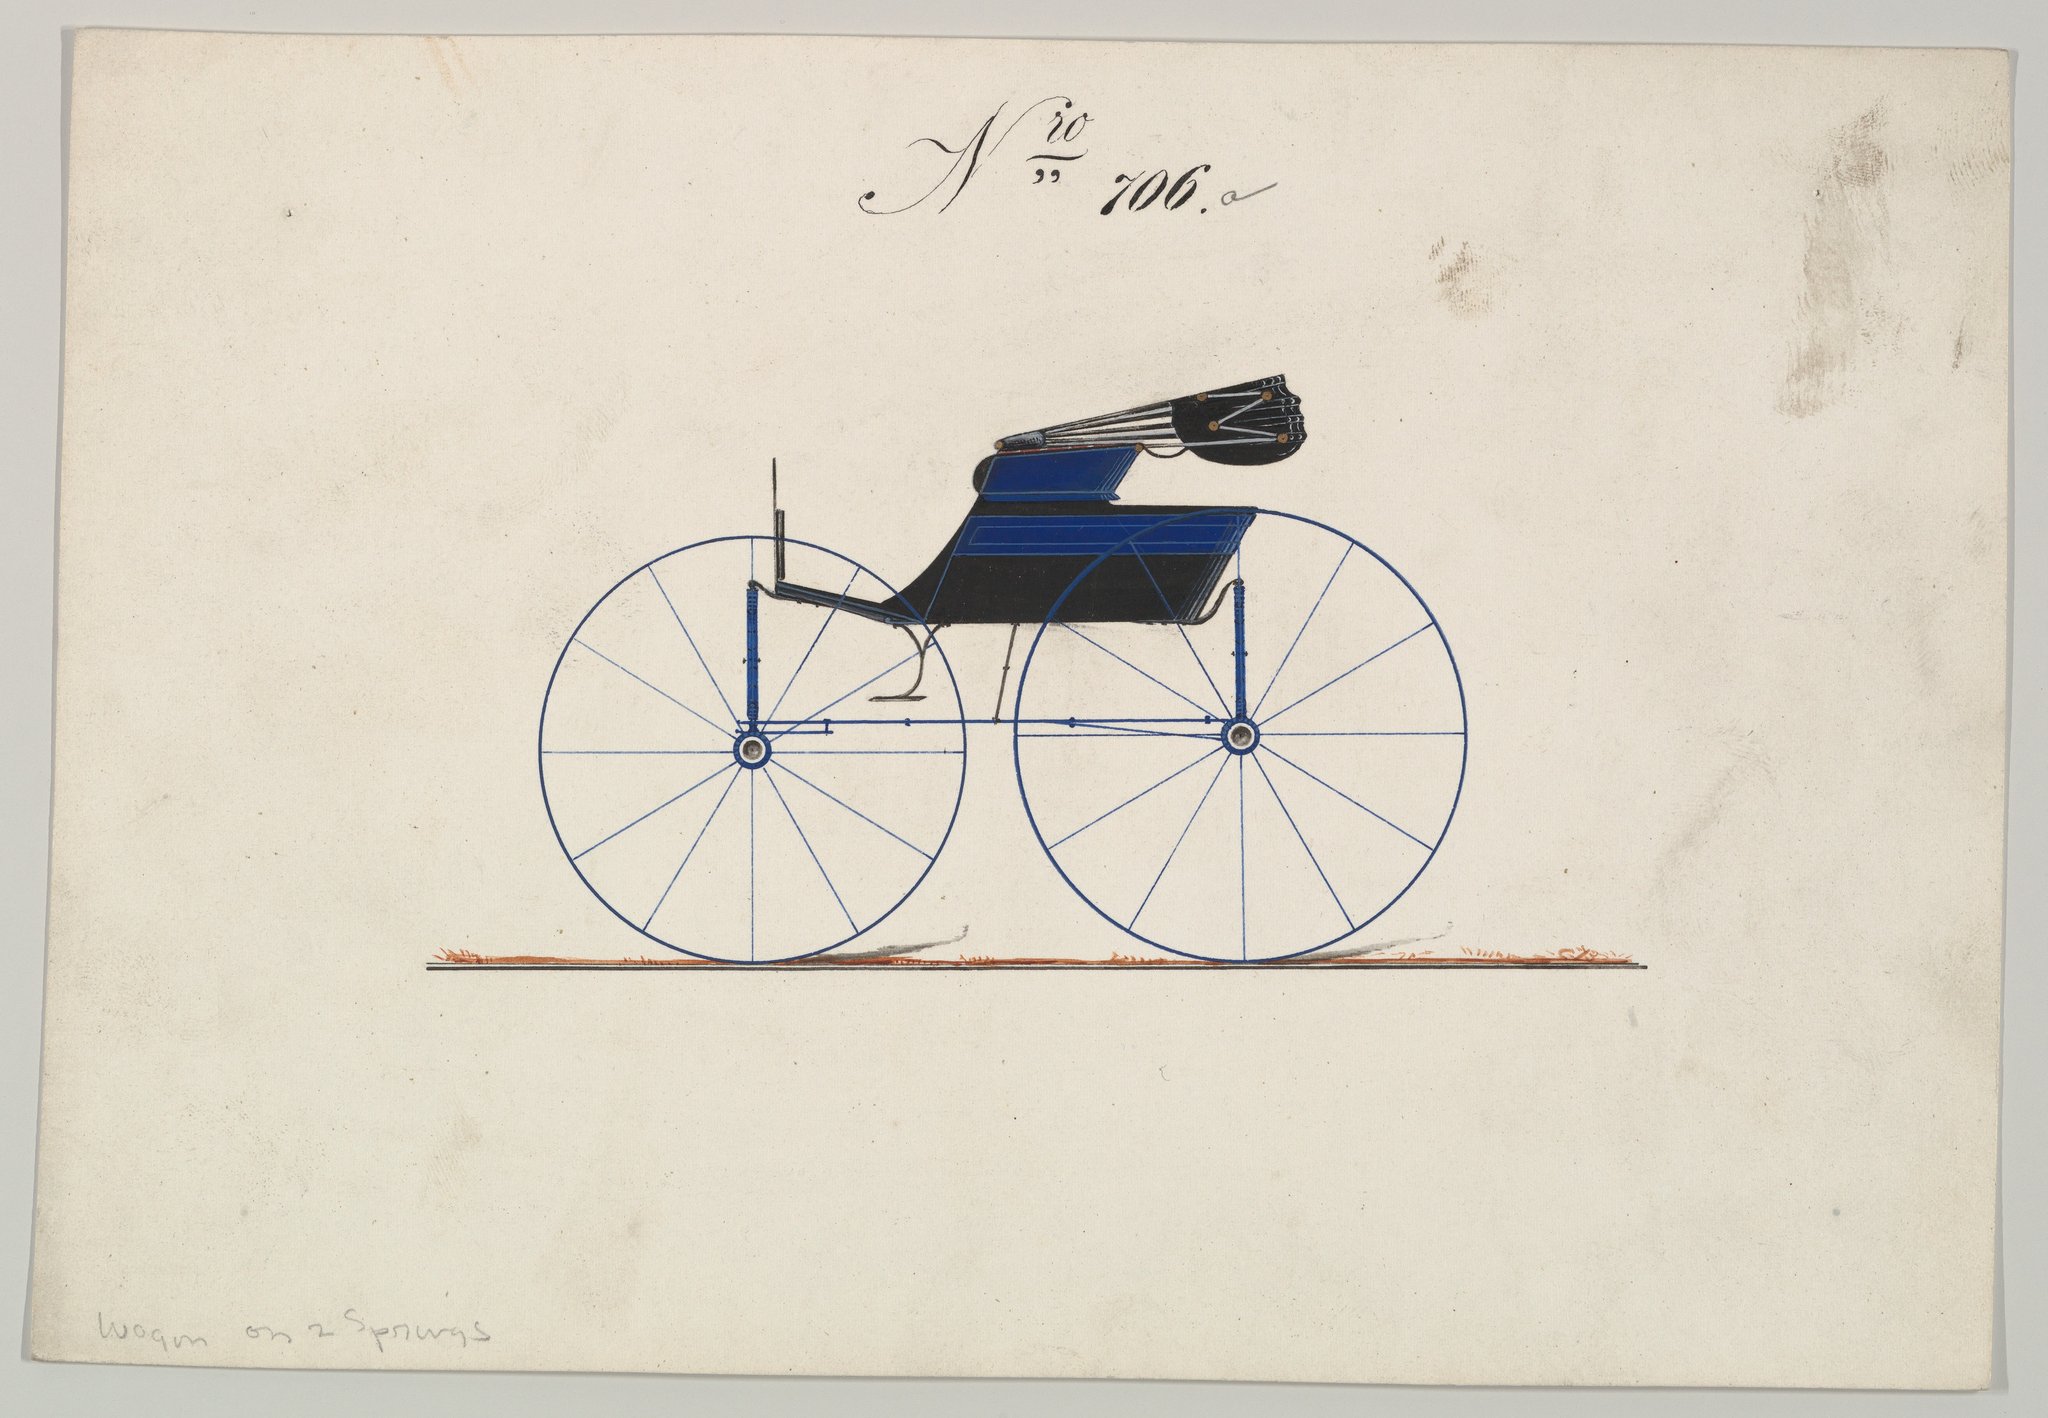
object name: drawing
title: Design for Wagon, no. 706a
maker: brewster & co.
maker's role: manufacturer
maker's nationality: american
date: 1860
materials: gouache, ink, watercolor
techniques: pen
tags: carriages